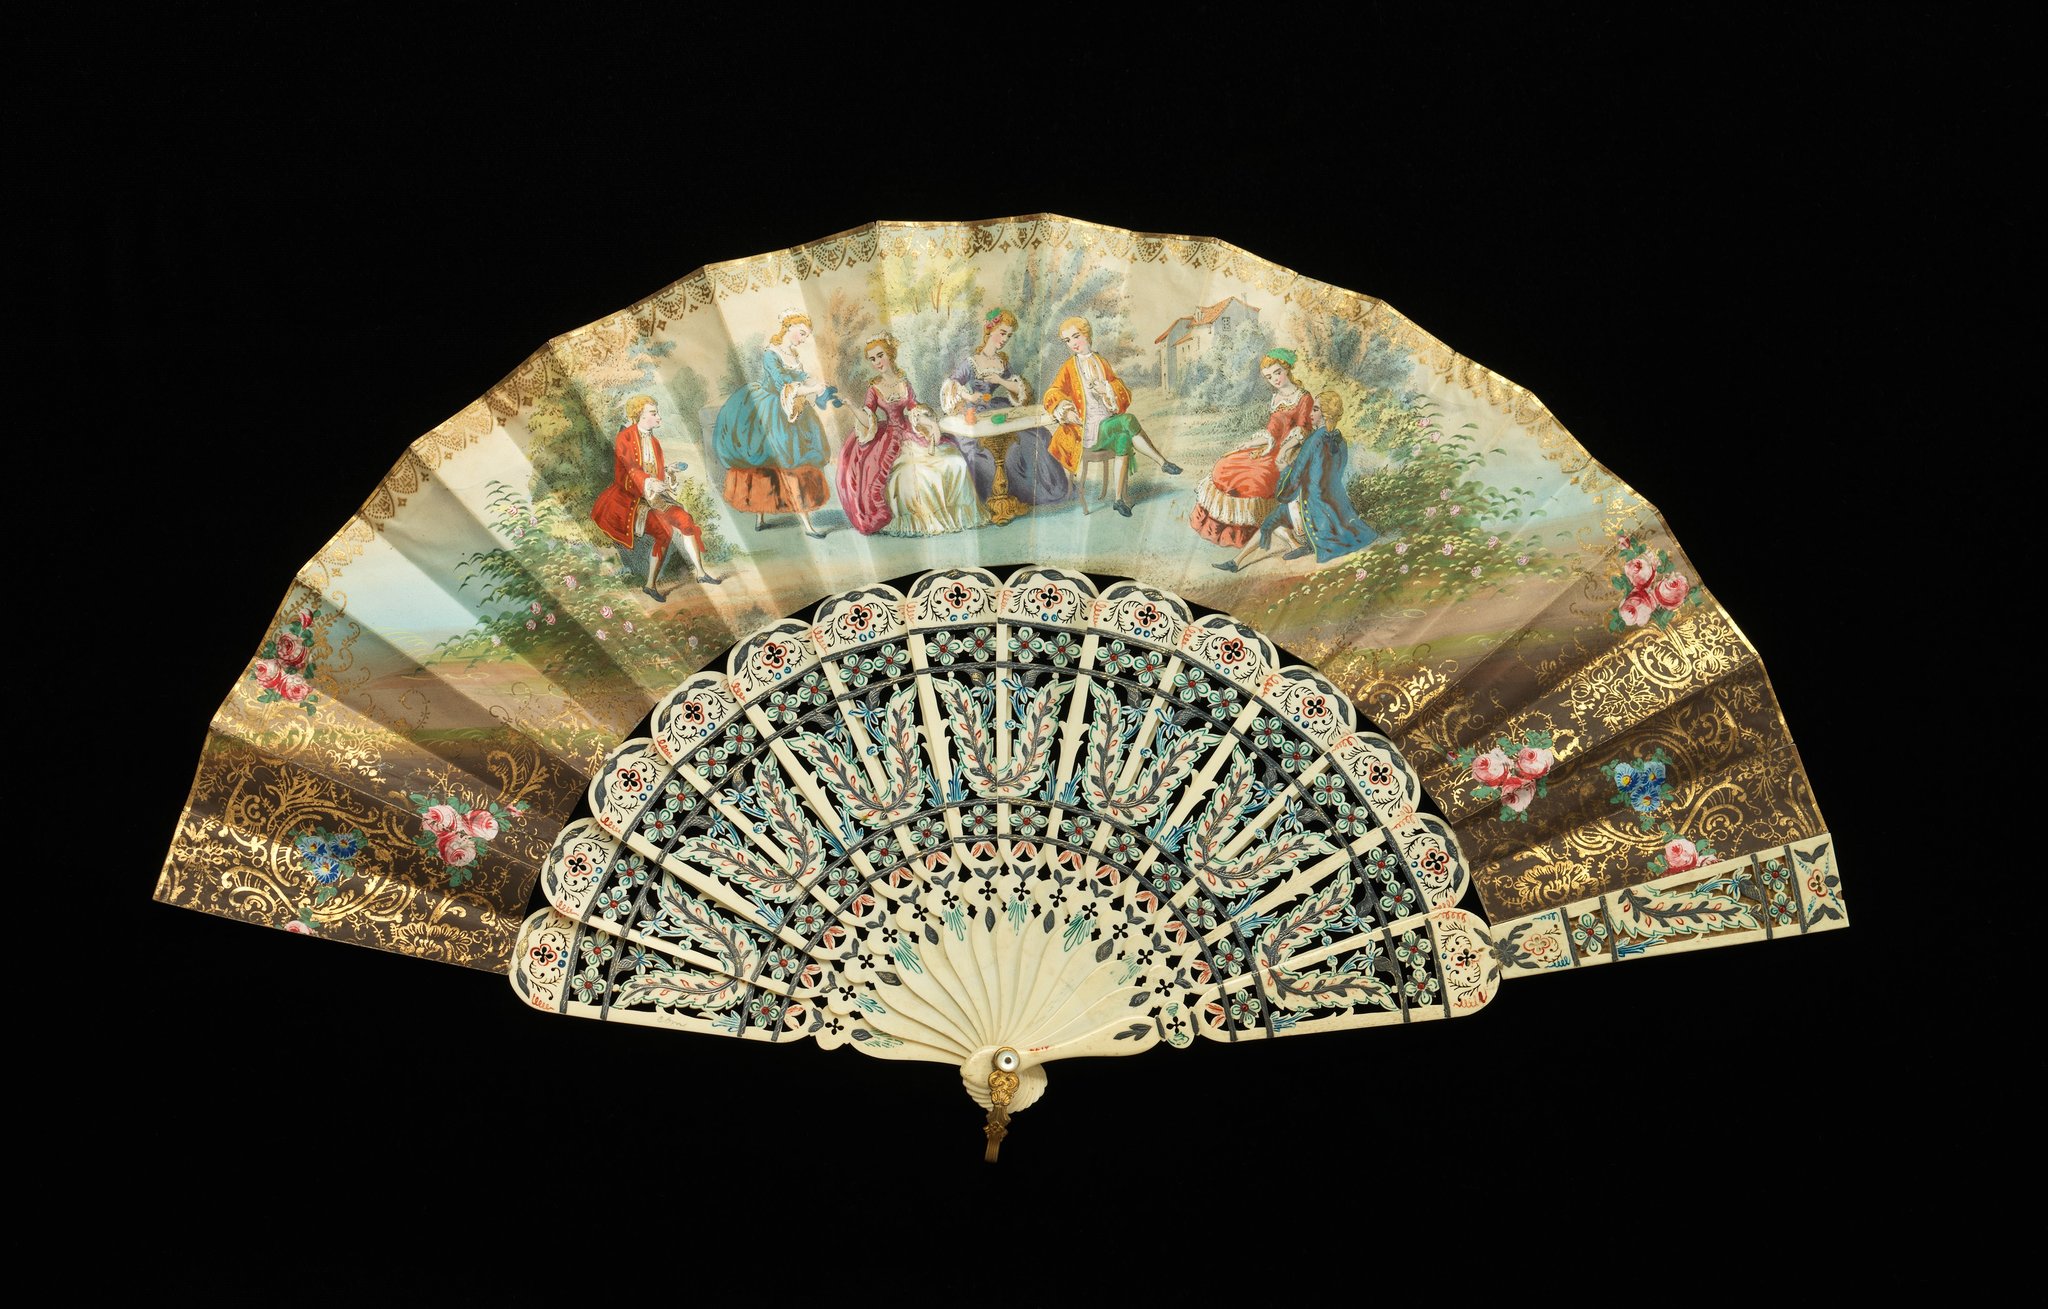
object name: fan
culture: spanish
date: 1860-1869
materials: ivory, metal, mother of pearl, paper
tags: men,women,flowers,drinking